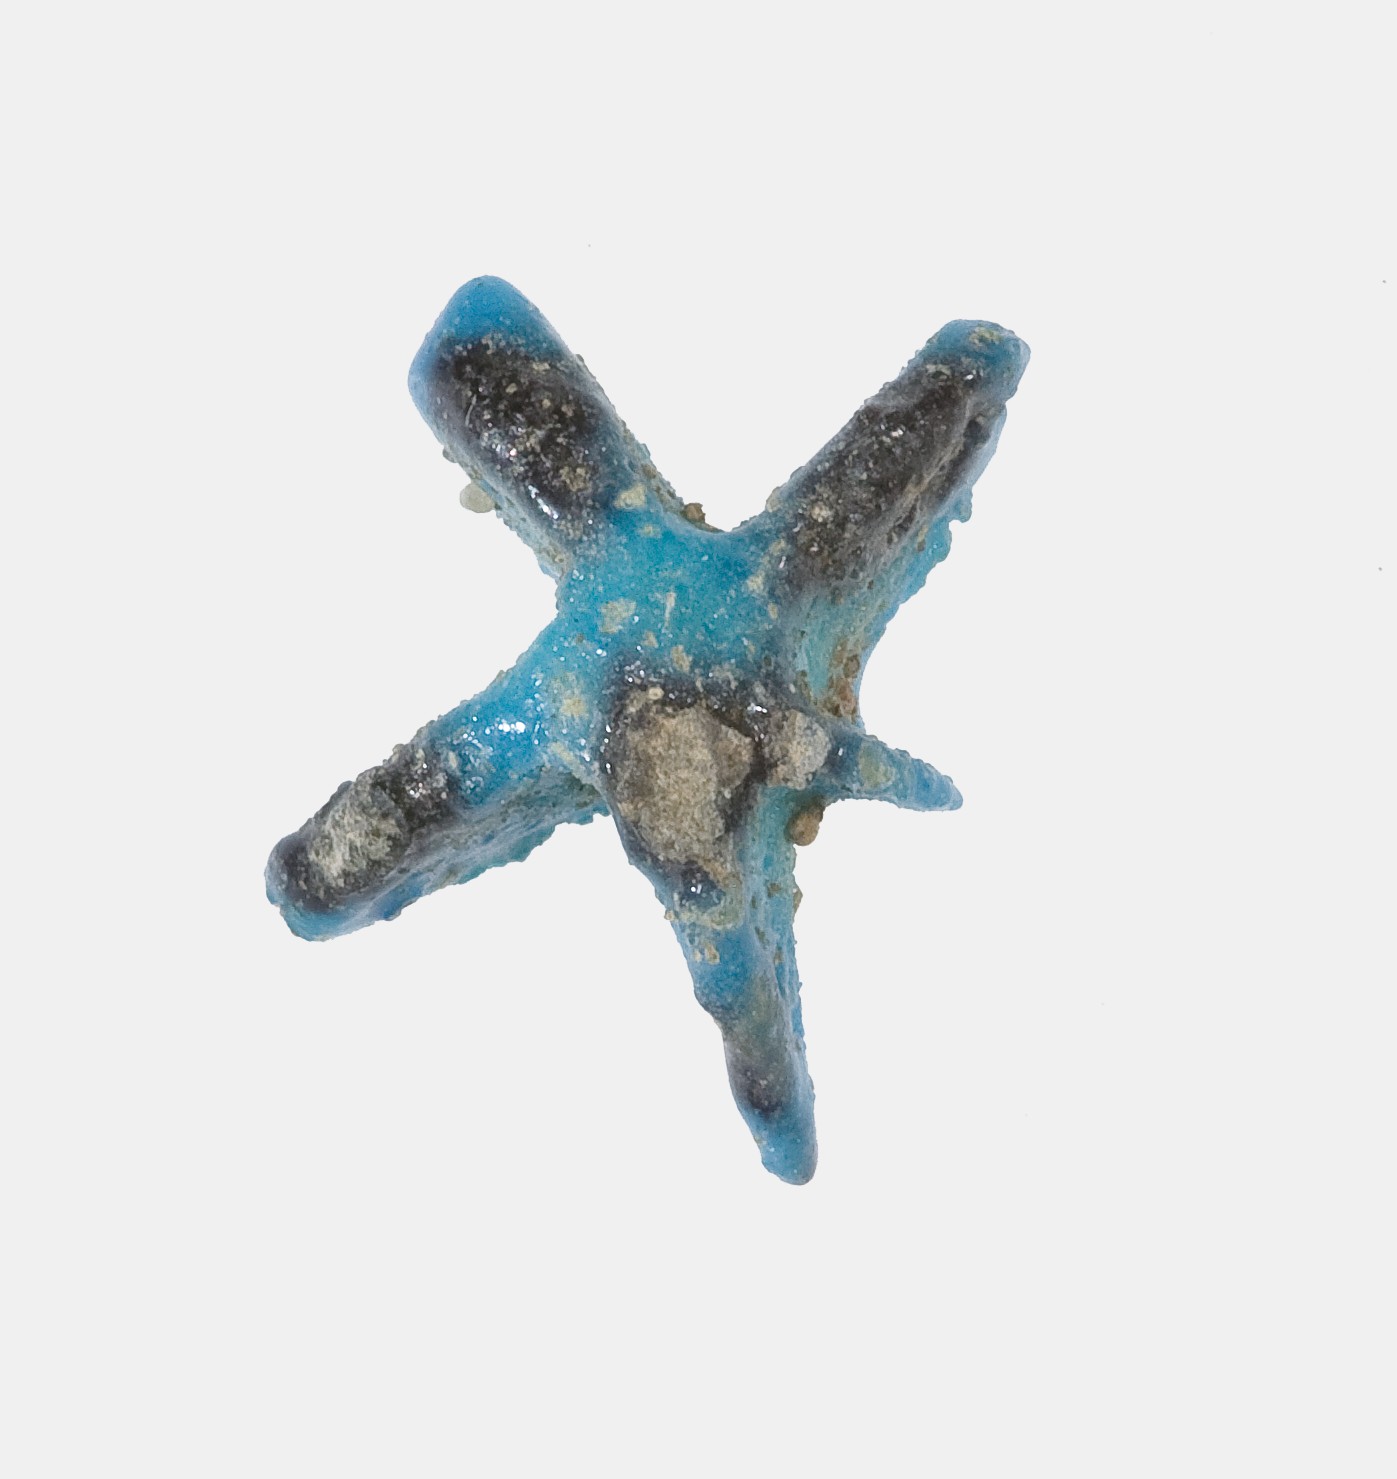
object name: amulet, star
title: Star Amulet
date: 1802-1450 BCE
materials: faience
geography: egypt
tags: stars